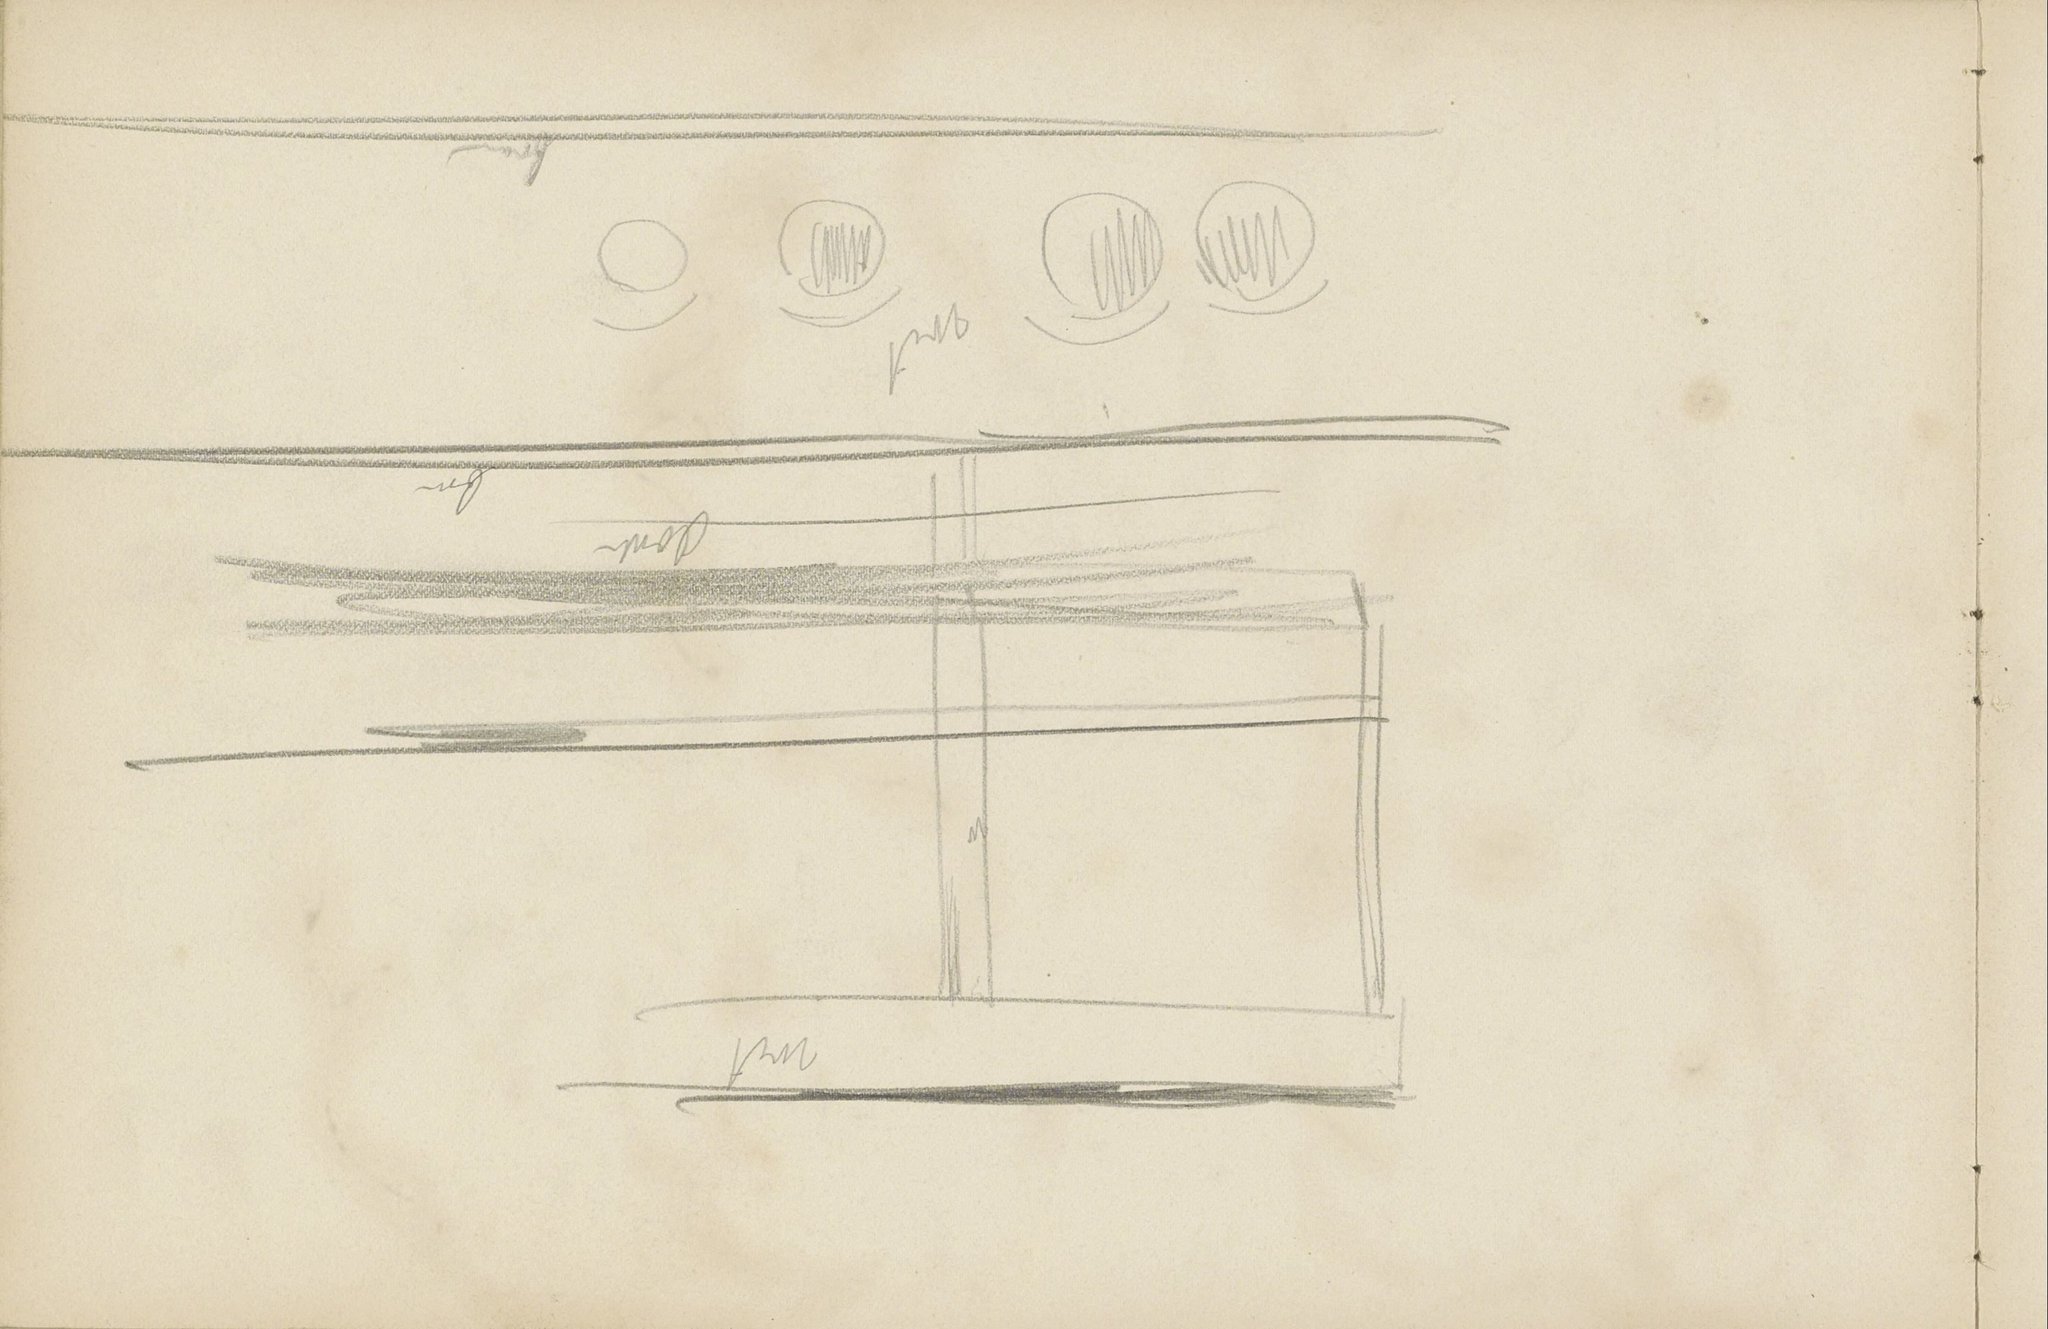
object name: sketchbook leaf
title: Ontwerp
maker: carel adolph lion cachet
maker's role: draughtsman, print maker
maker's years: 1864-1945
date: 1908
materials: paper, pencil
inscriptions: kleurnotitie, handgeschreven in potlood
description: Blad 24 verso uit een schetsboek met 25 bladen.